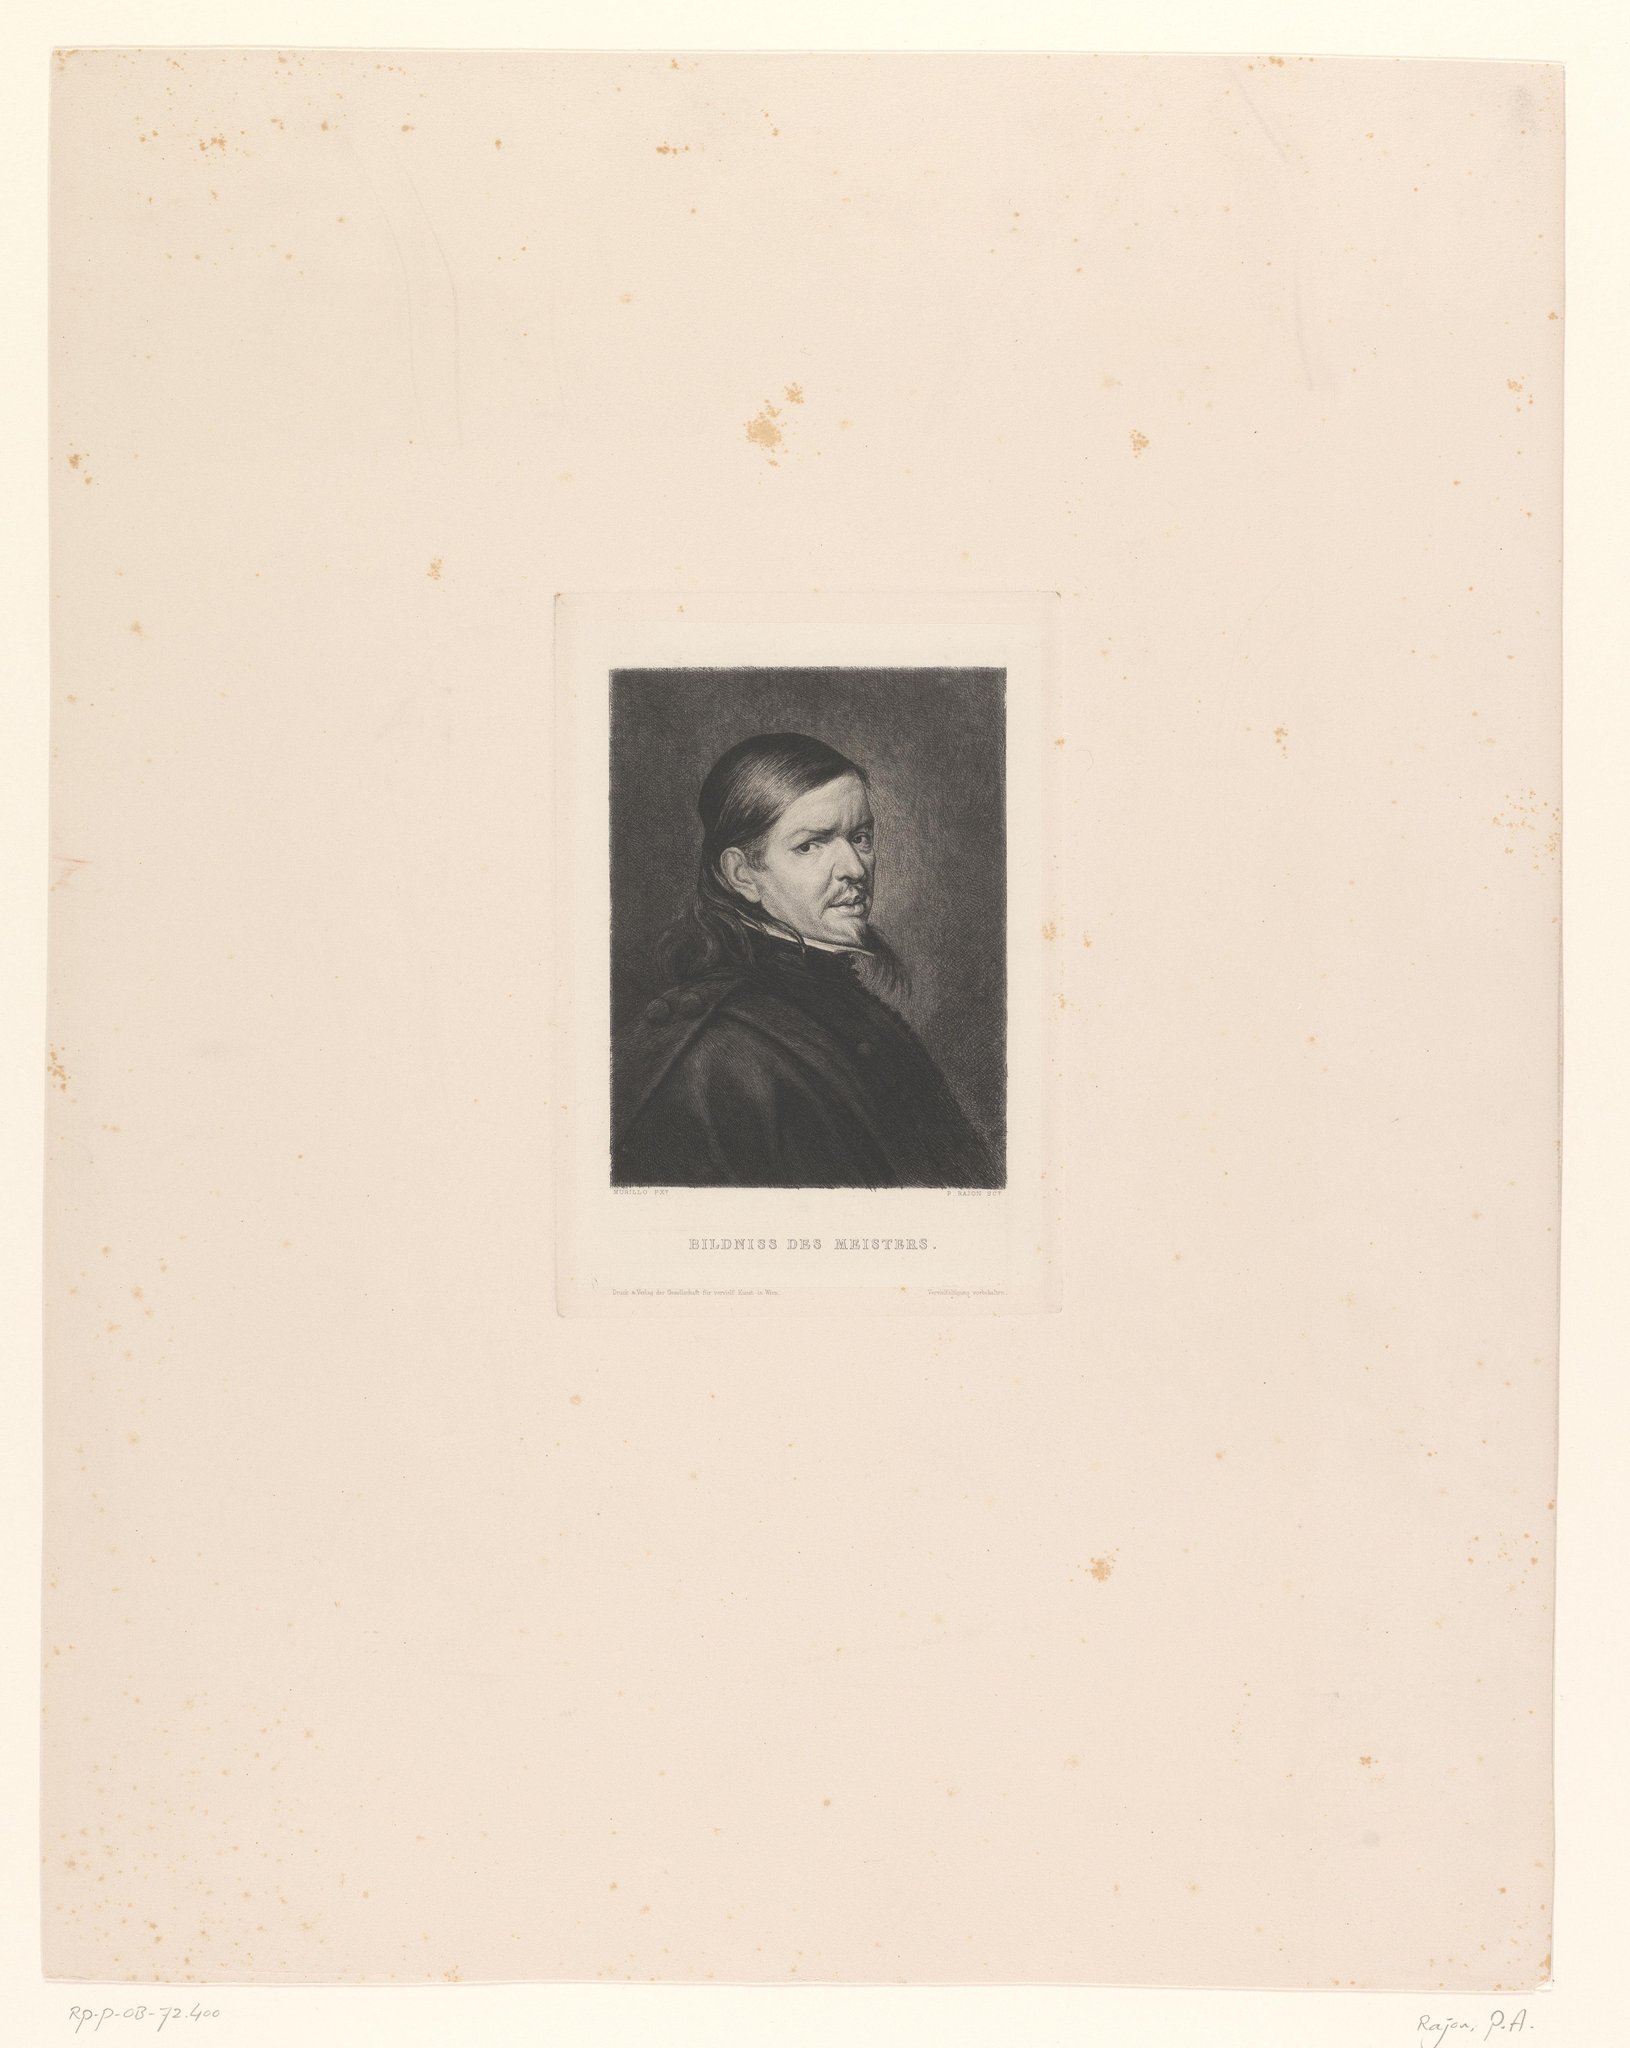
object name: print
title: Portret van Bartolomé Esteban Murillo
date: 1852-1888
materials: paper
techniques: etching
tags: painter, bartolomé esteban murillo, historical persons, portrait, self-portrait of painter